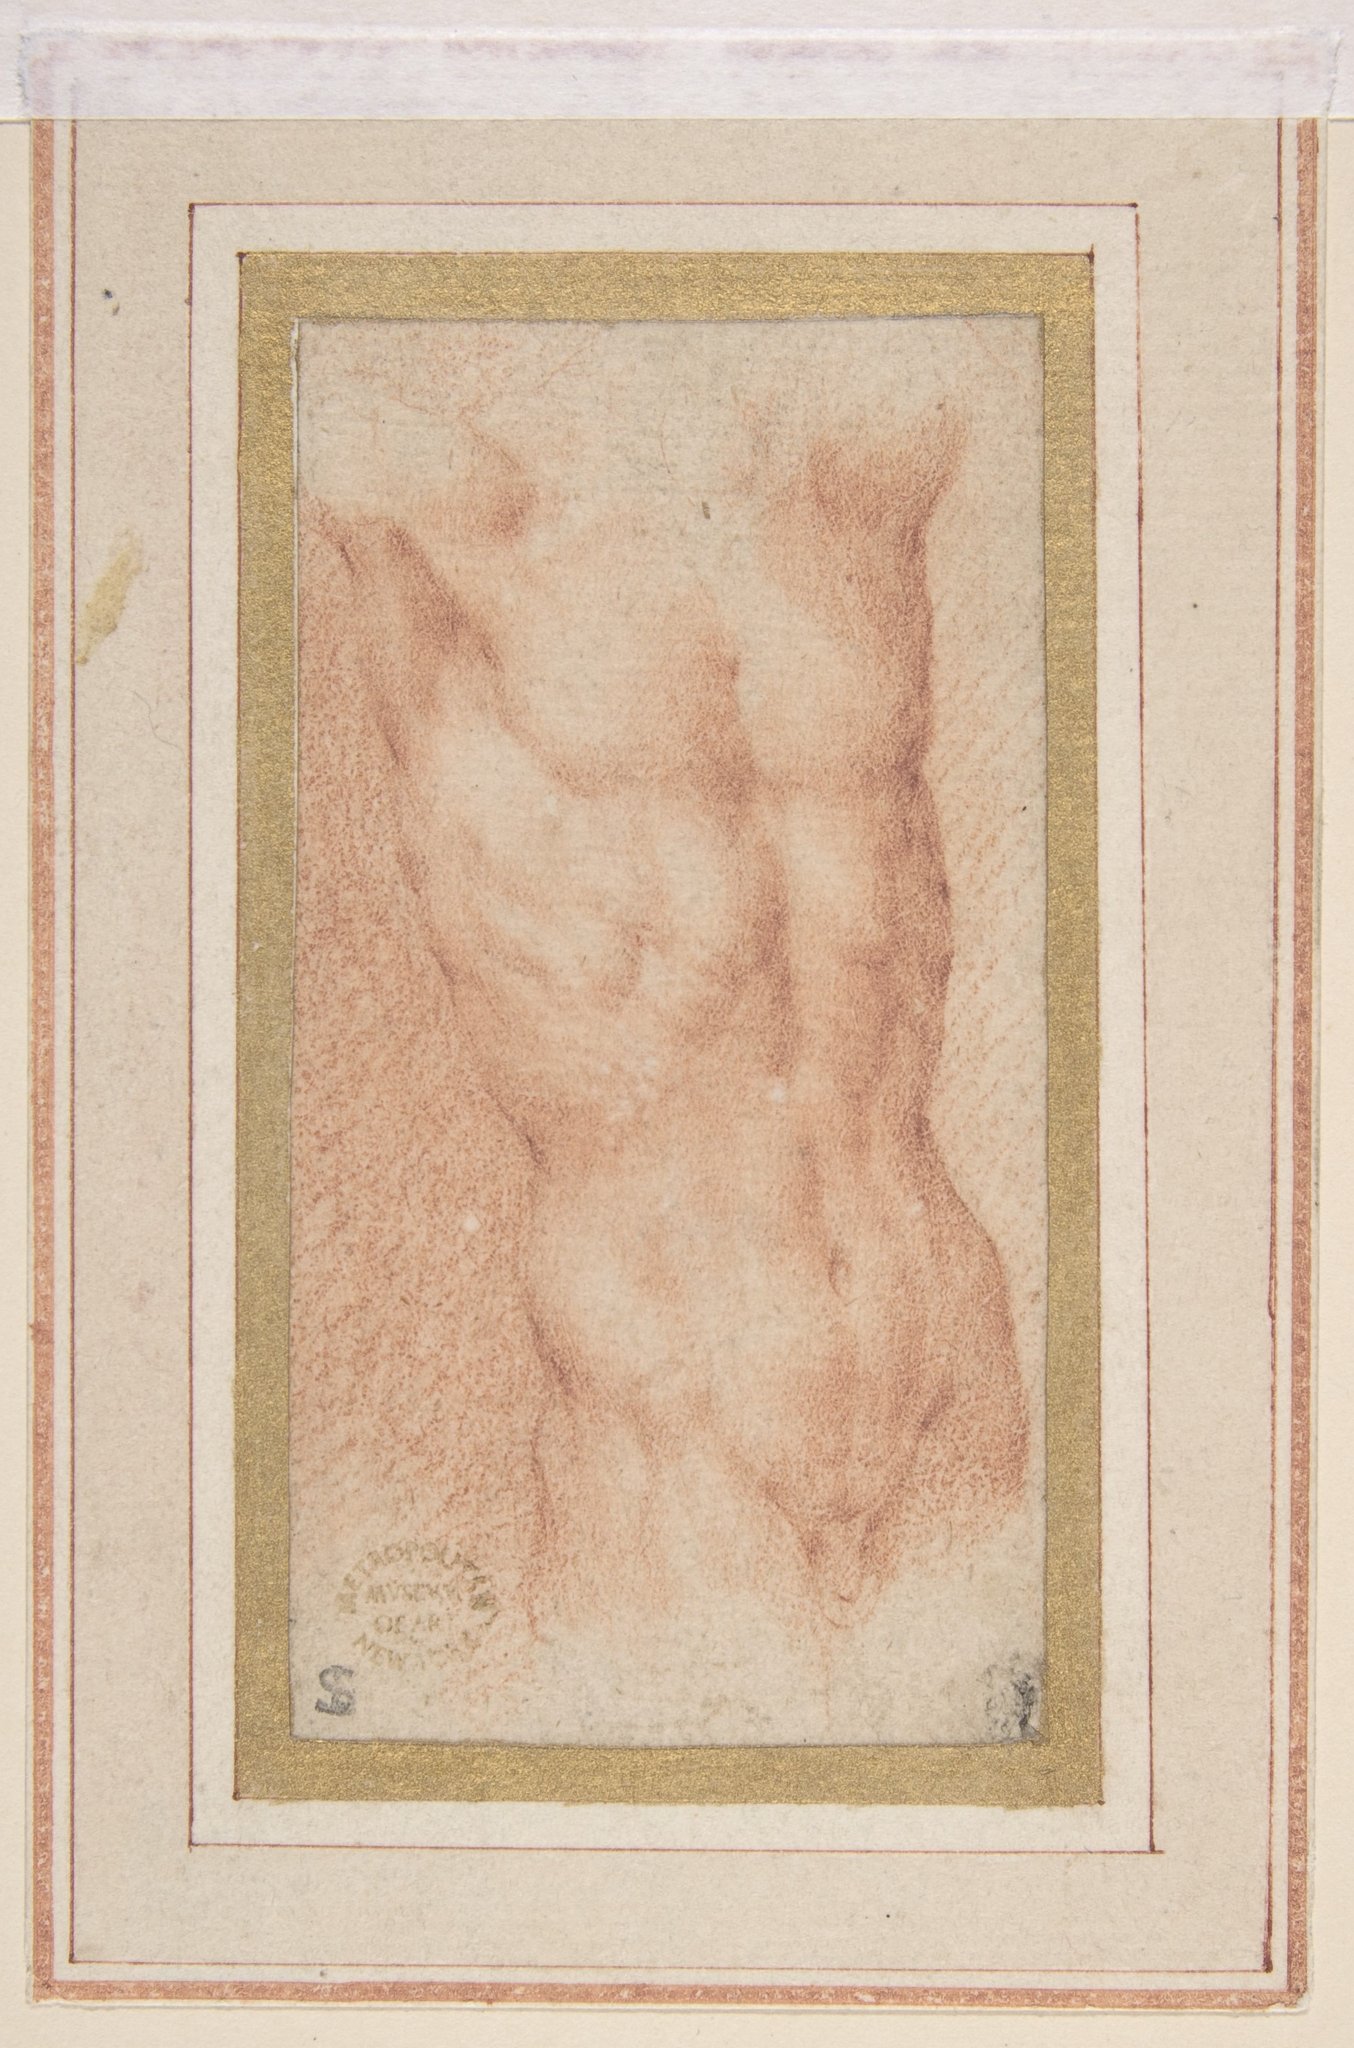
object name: drawing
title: Male Nude Torso with Raised Arms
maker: parmigianino (girolamo francesco maria mazzola)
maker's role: artist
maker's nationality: italian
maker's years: 1503-1540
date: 1522-1524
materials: chalk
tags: male nudes